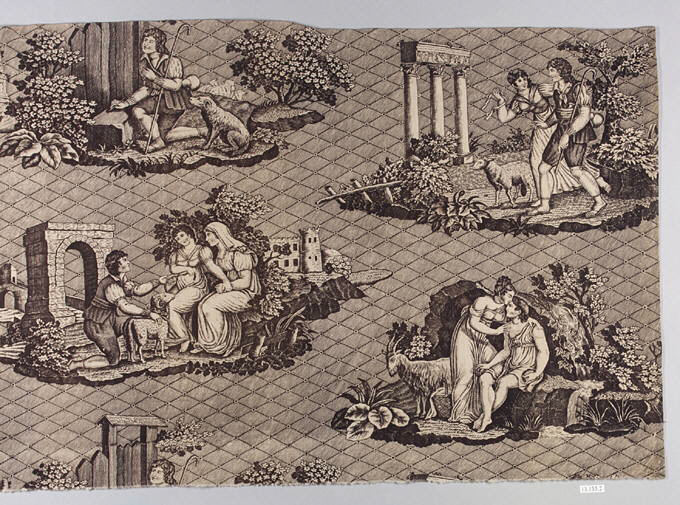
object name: furnishing textile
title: Pictorial print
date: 1815-1825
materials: cotton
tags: men,women,dogs,sheep,flowers,shepherds